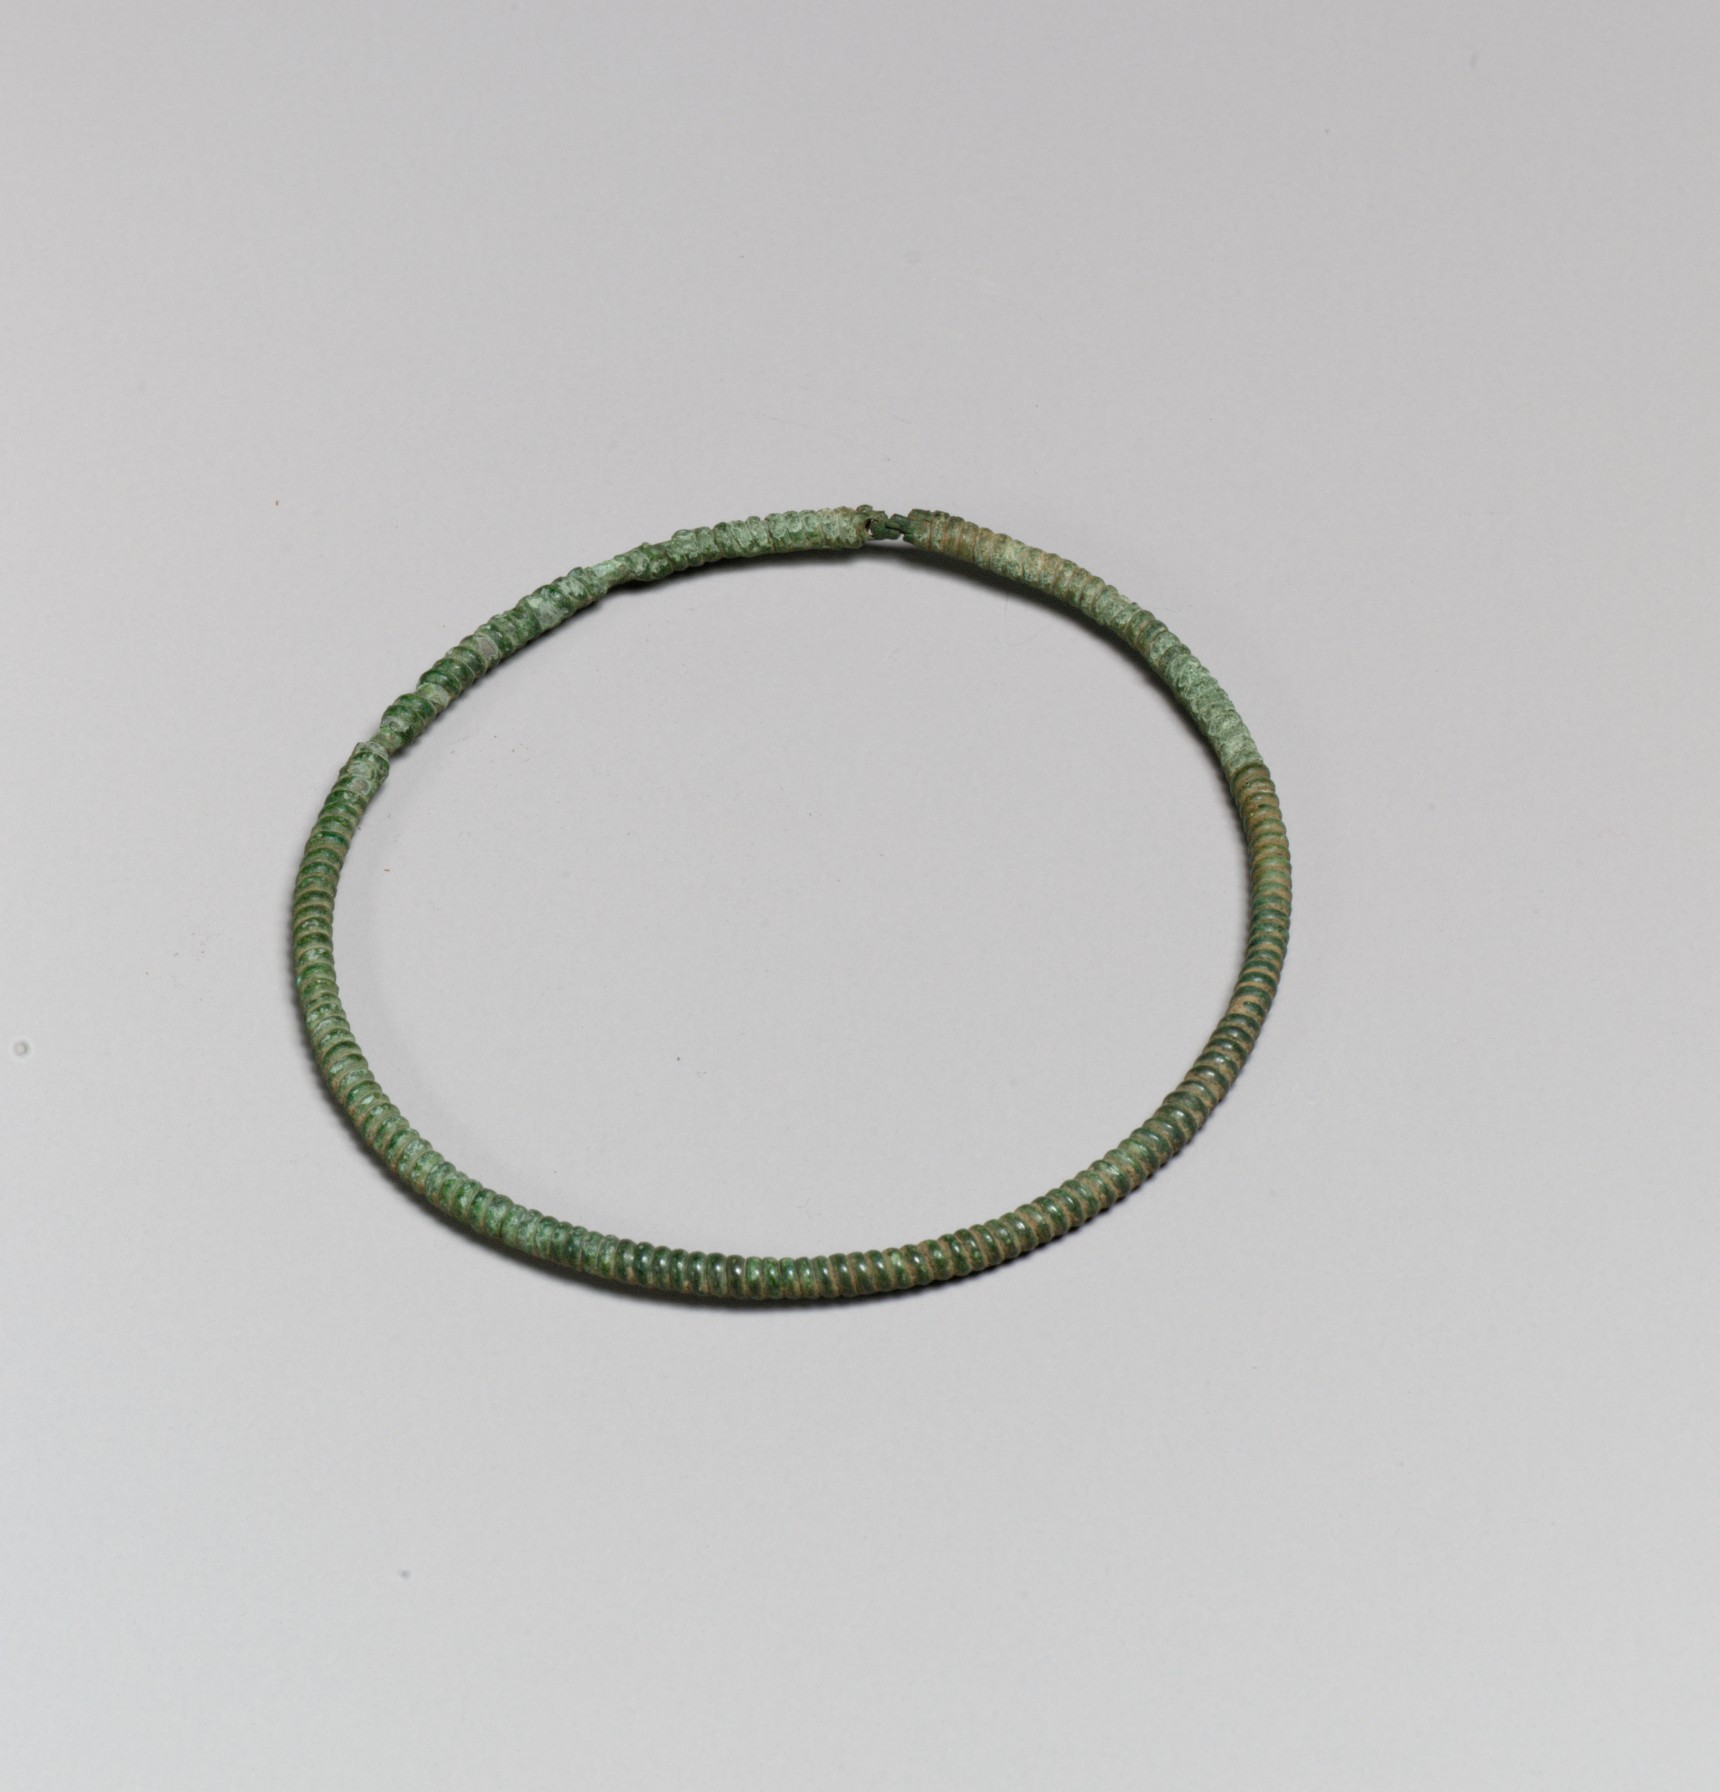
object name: bracelet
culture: roman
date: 1-300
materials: bronze